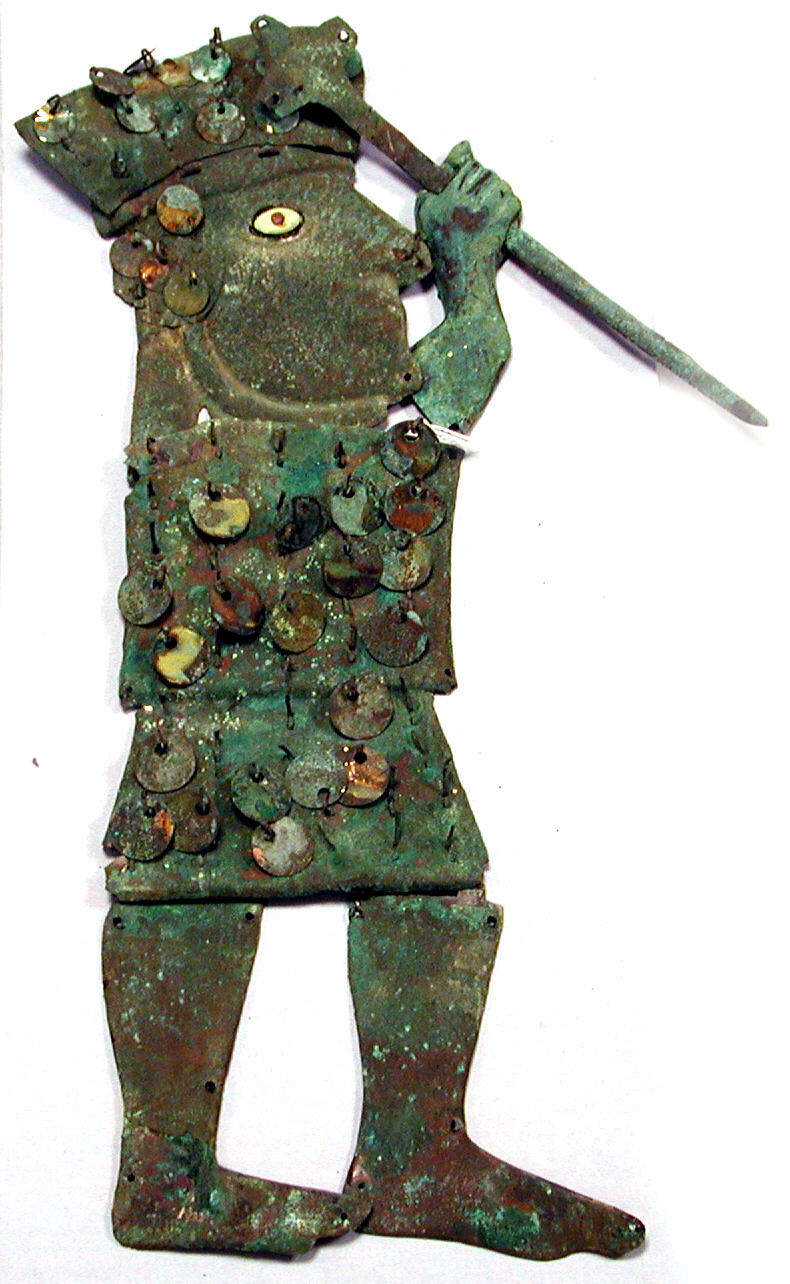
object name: ornament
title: Profile Warrior Ornament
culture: moche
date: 501-700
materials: shell, metal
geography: peru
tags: human figures,weapons